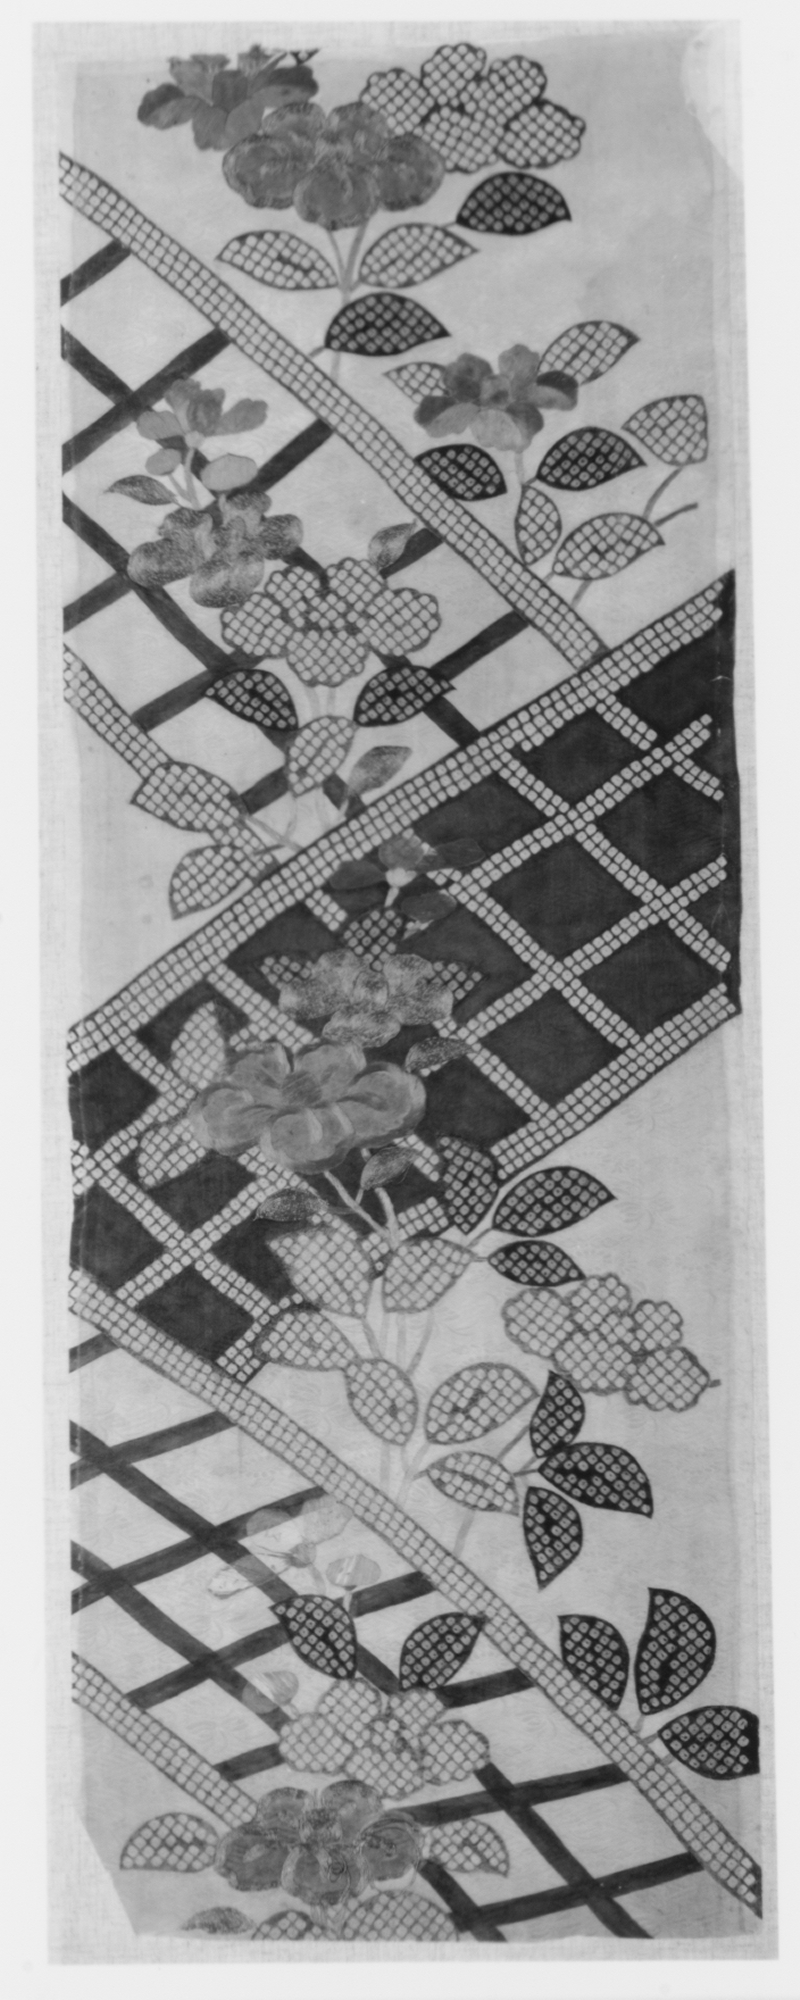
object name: piece from a kosode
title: Piece from a Kosode with Camellias and Fence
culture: japanese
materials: metal thread, silk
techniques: damask, dyeing, embroidery, resist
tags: leaves